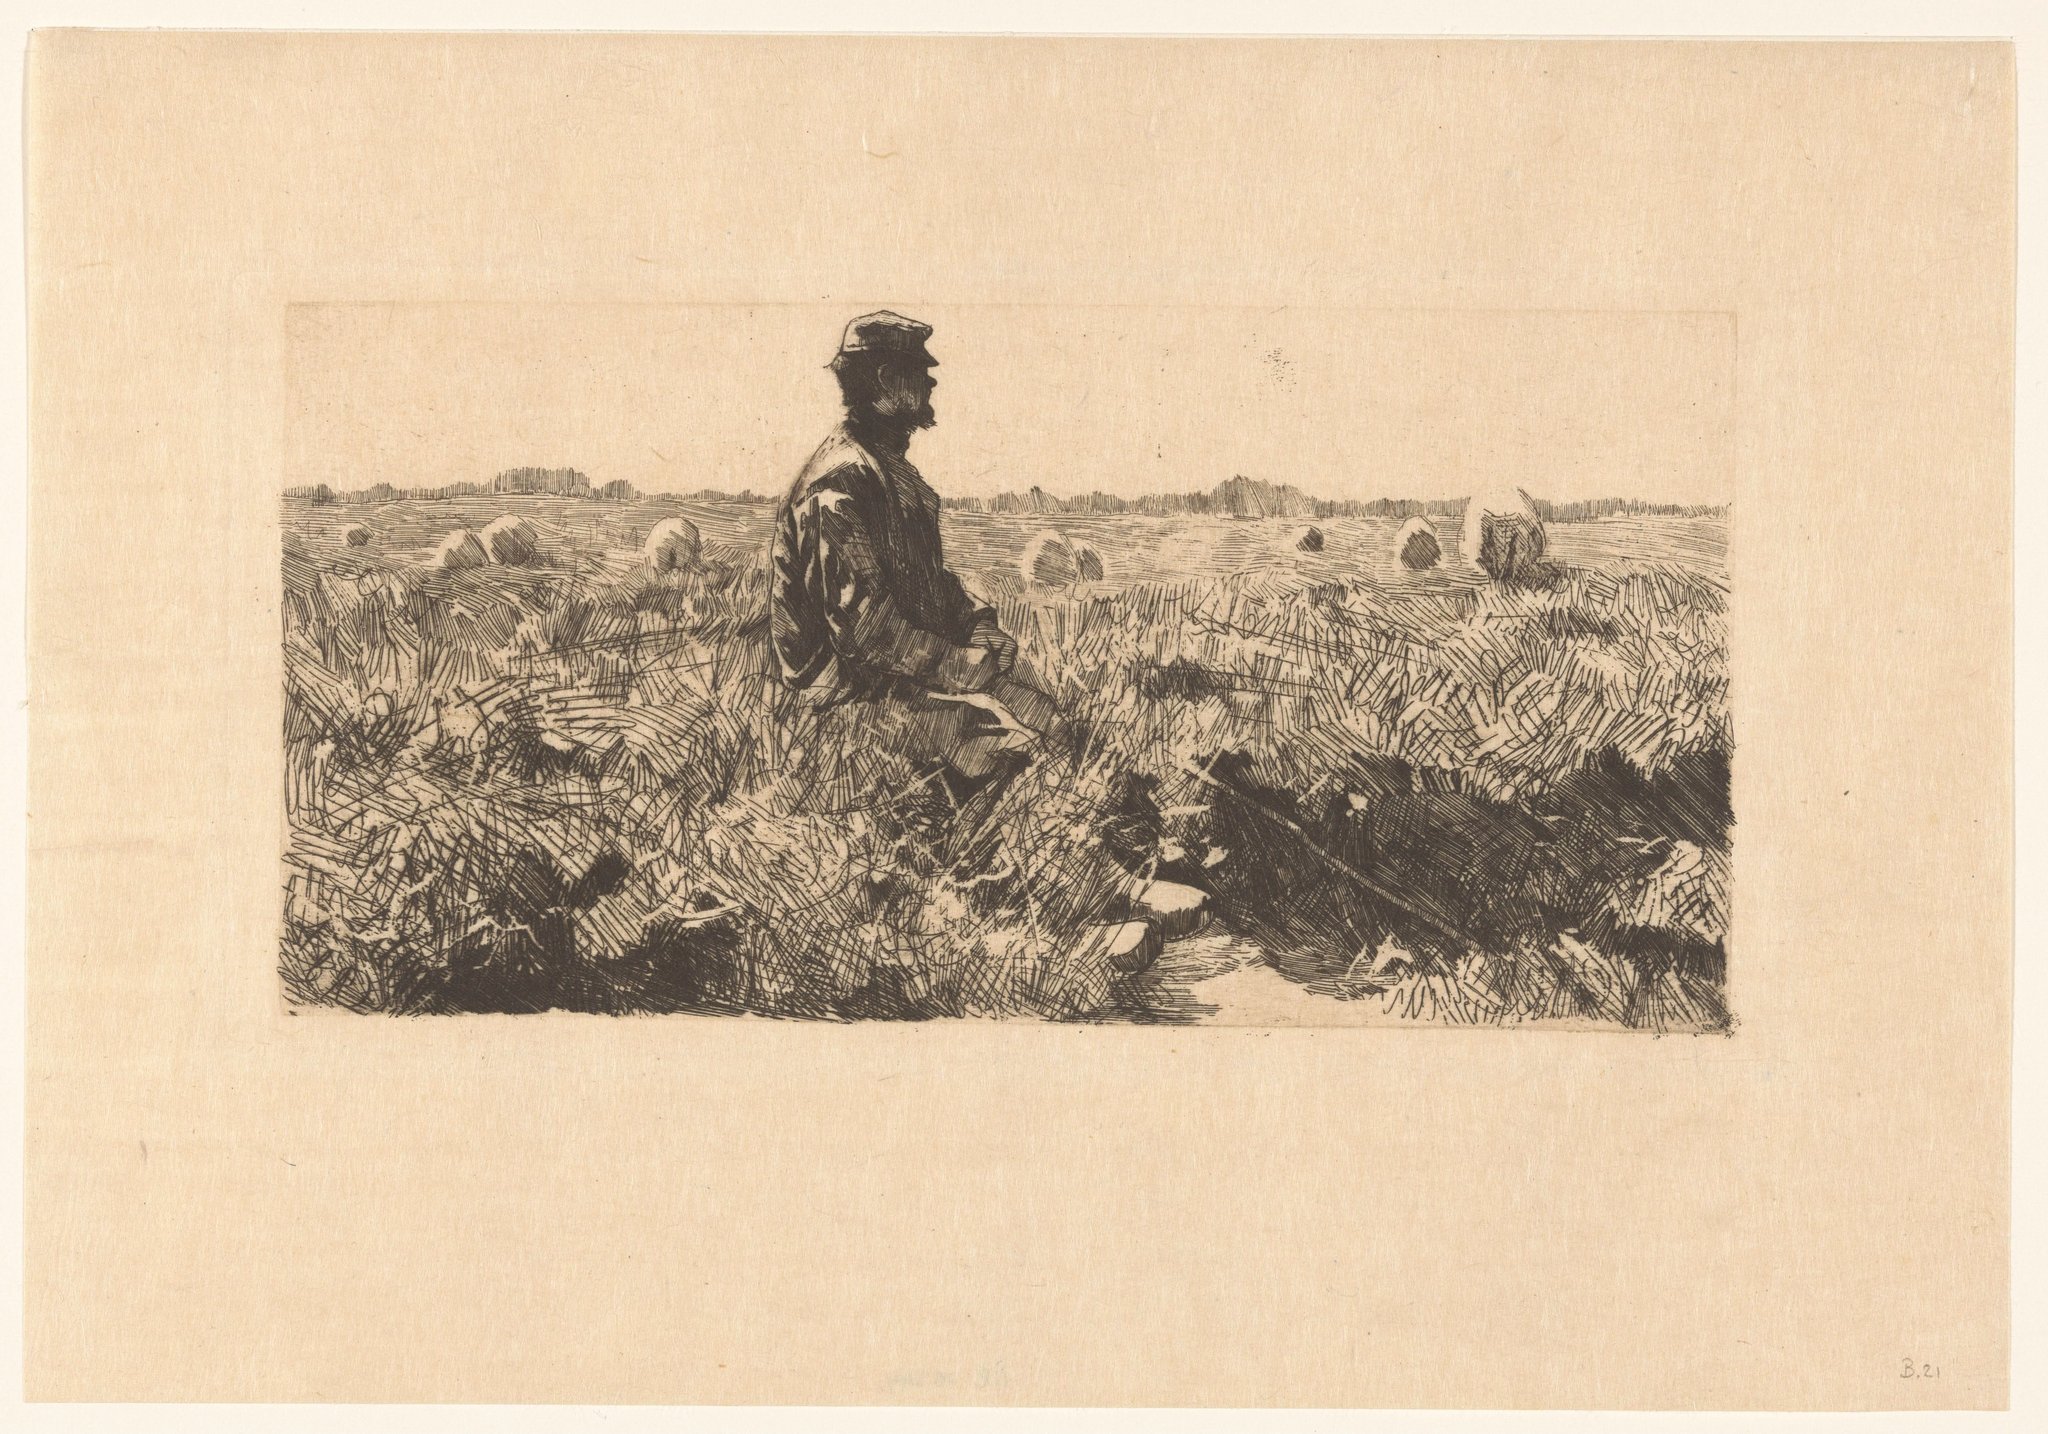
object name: print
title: Zittende schaapherder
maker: willem witsen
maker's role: draughtsman, painter, print maker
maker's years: 1860-1923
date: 1885-1886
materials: paper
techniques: etching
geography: ewijkshoeve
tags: meadow, pasture, shepherd's crook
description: Schaapherder en profil naar rechts in een weiland.